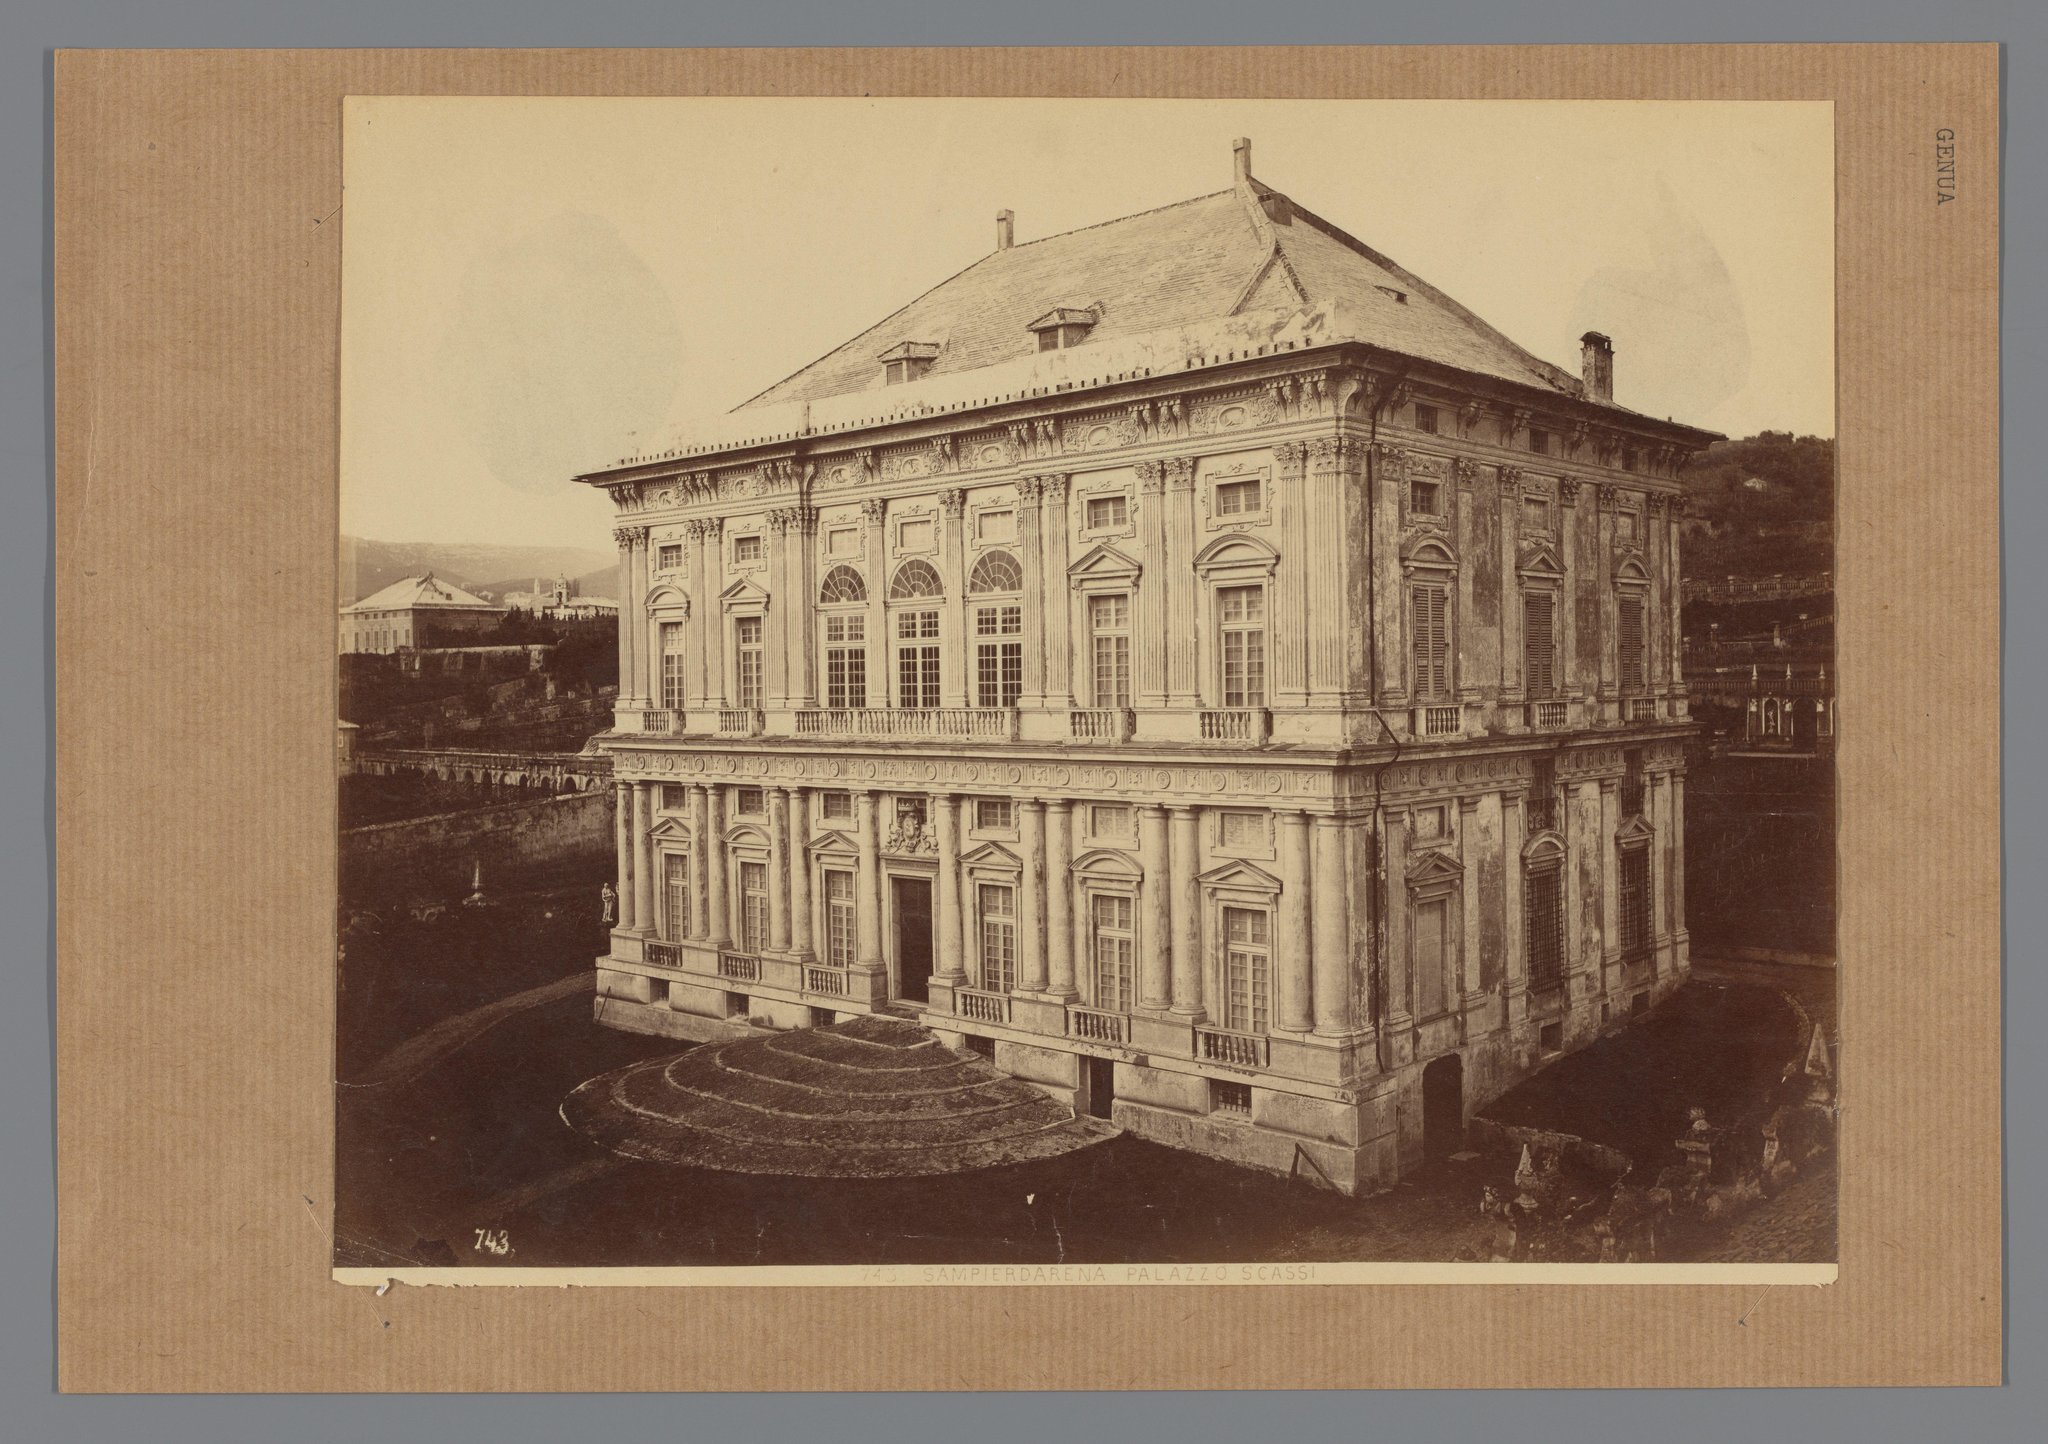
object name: photograph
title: Italië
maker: Anonymous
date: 1880-1910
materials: photographic support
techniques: albumen print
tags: italy